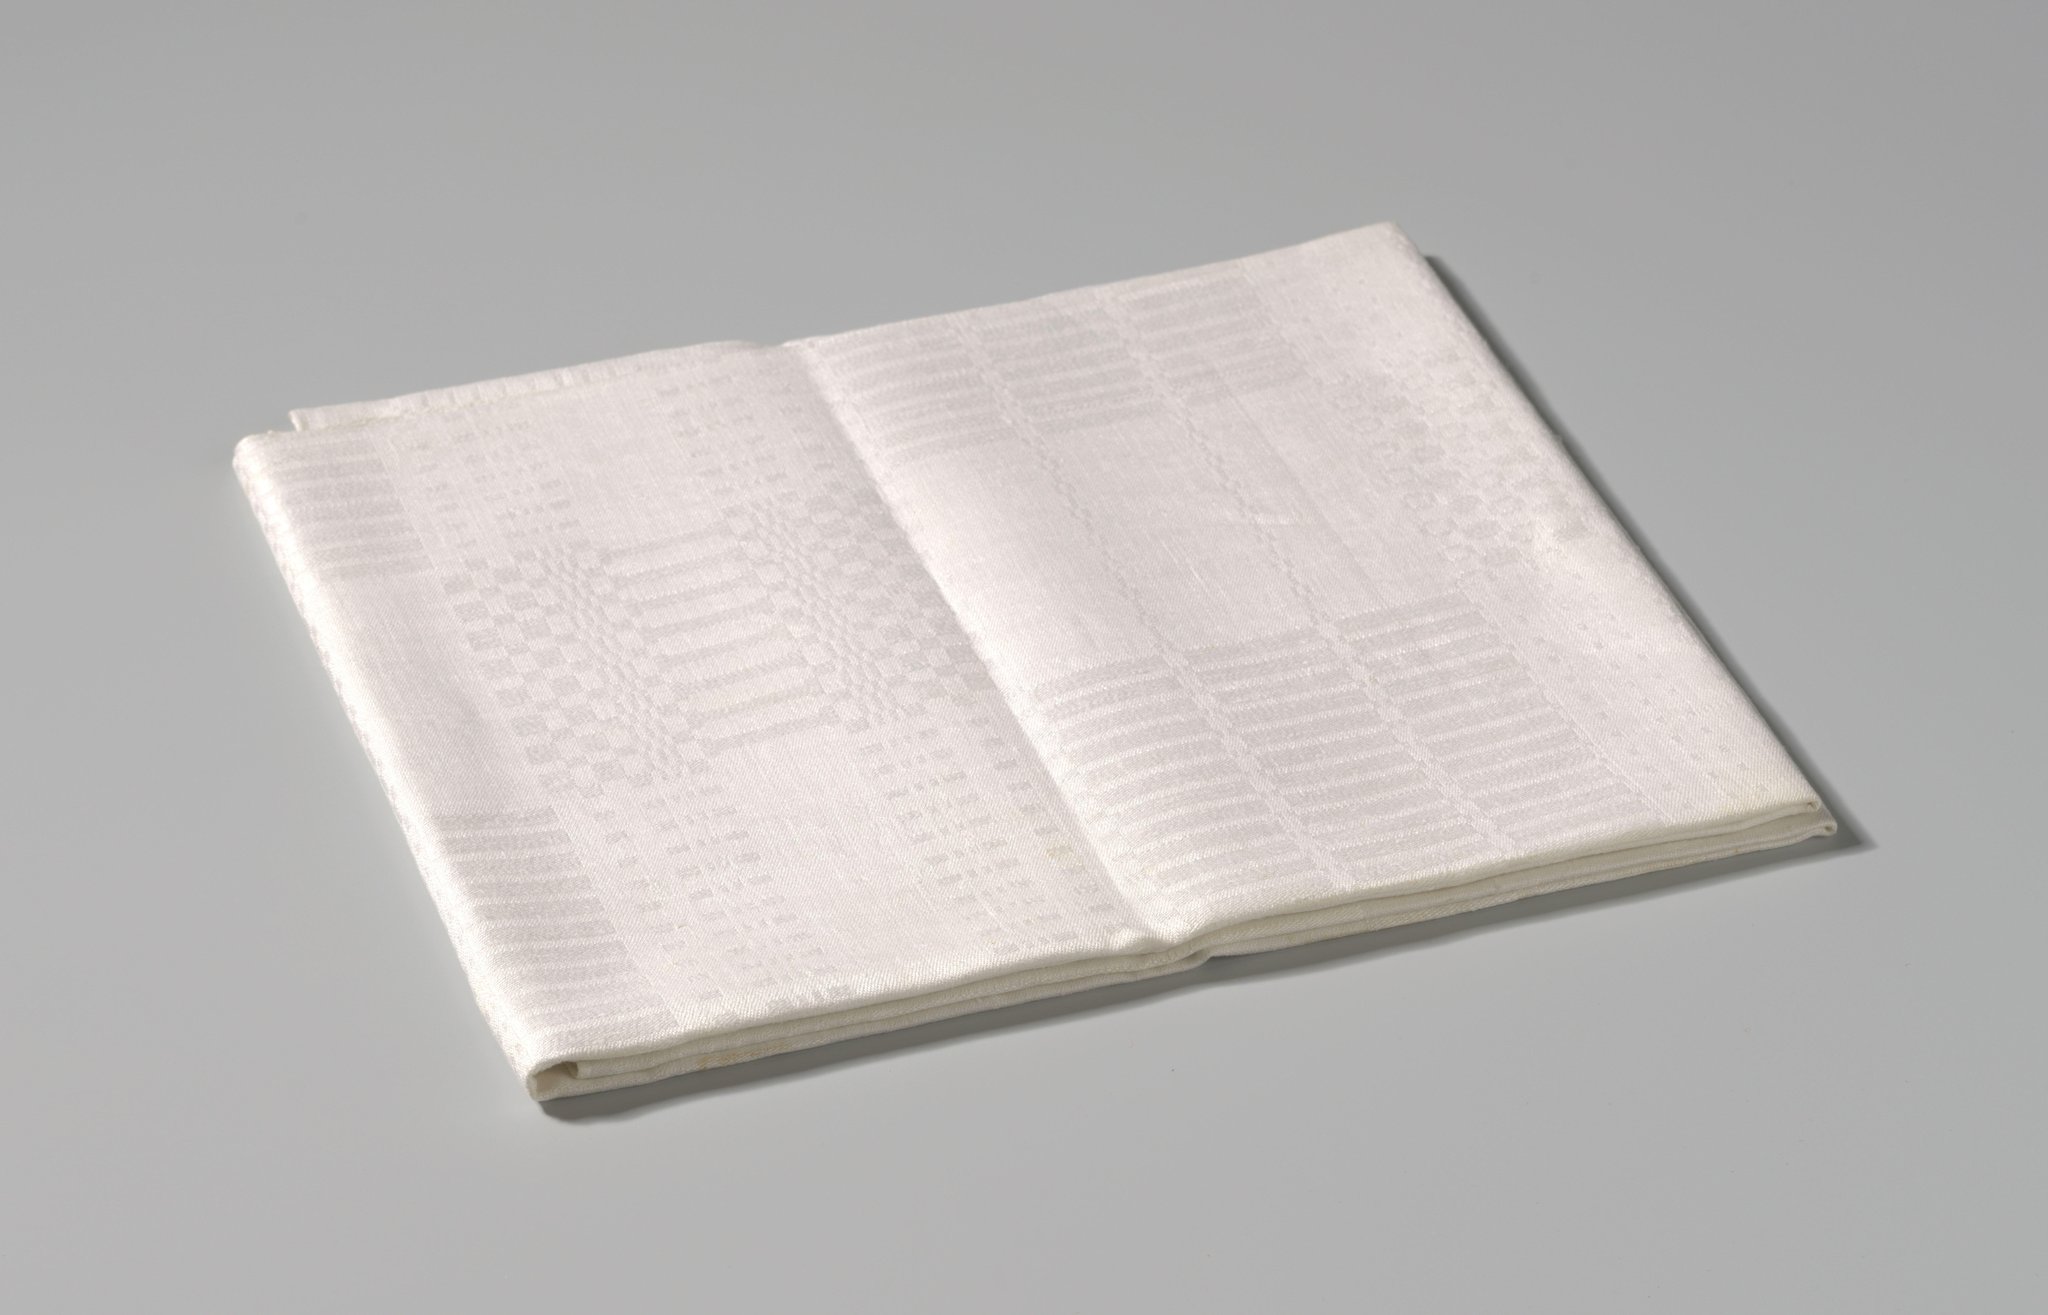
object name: napkin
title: Servet van linnen met pellenpatroon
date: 1785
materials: linen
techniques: peeled fabric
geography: northern netherlands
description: wit linnen servet met pellen patroon, merk SW 34 en 1785